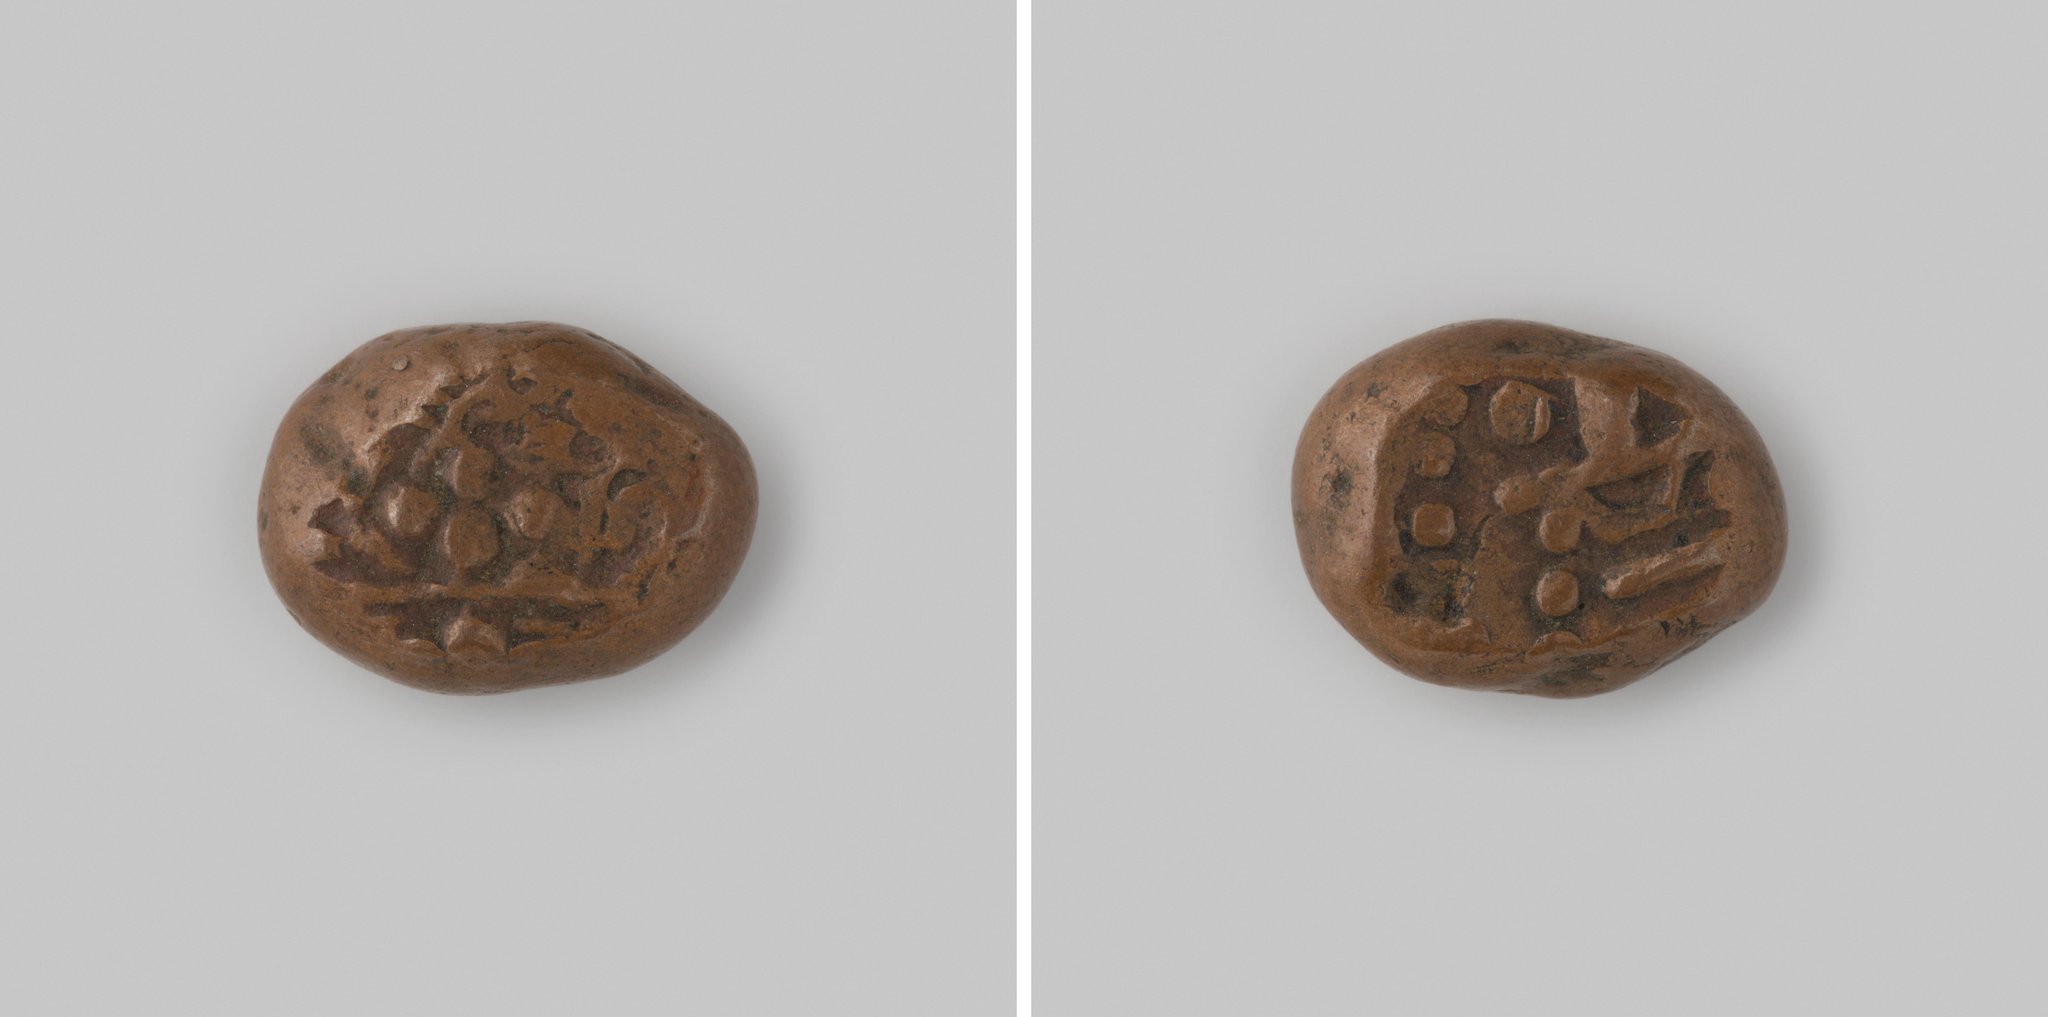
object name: coin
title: India, Tanjore,1/4 paisa,1700-1800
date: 1700-1800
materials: copper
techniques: striking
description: Koper-zilveren munt. Voorzijde: twee goddelijke figuren. Keerzijde: lingam: symbool van de verteniging van man en vrouw.